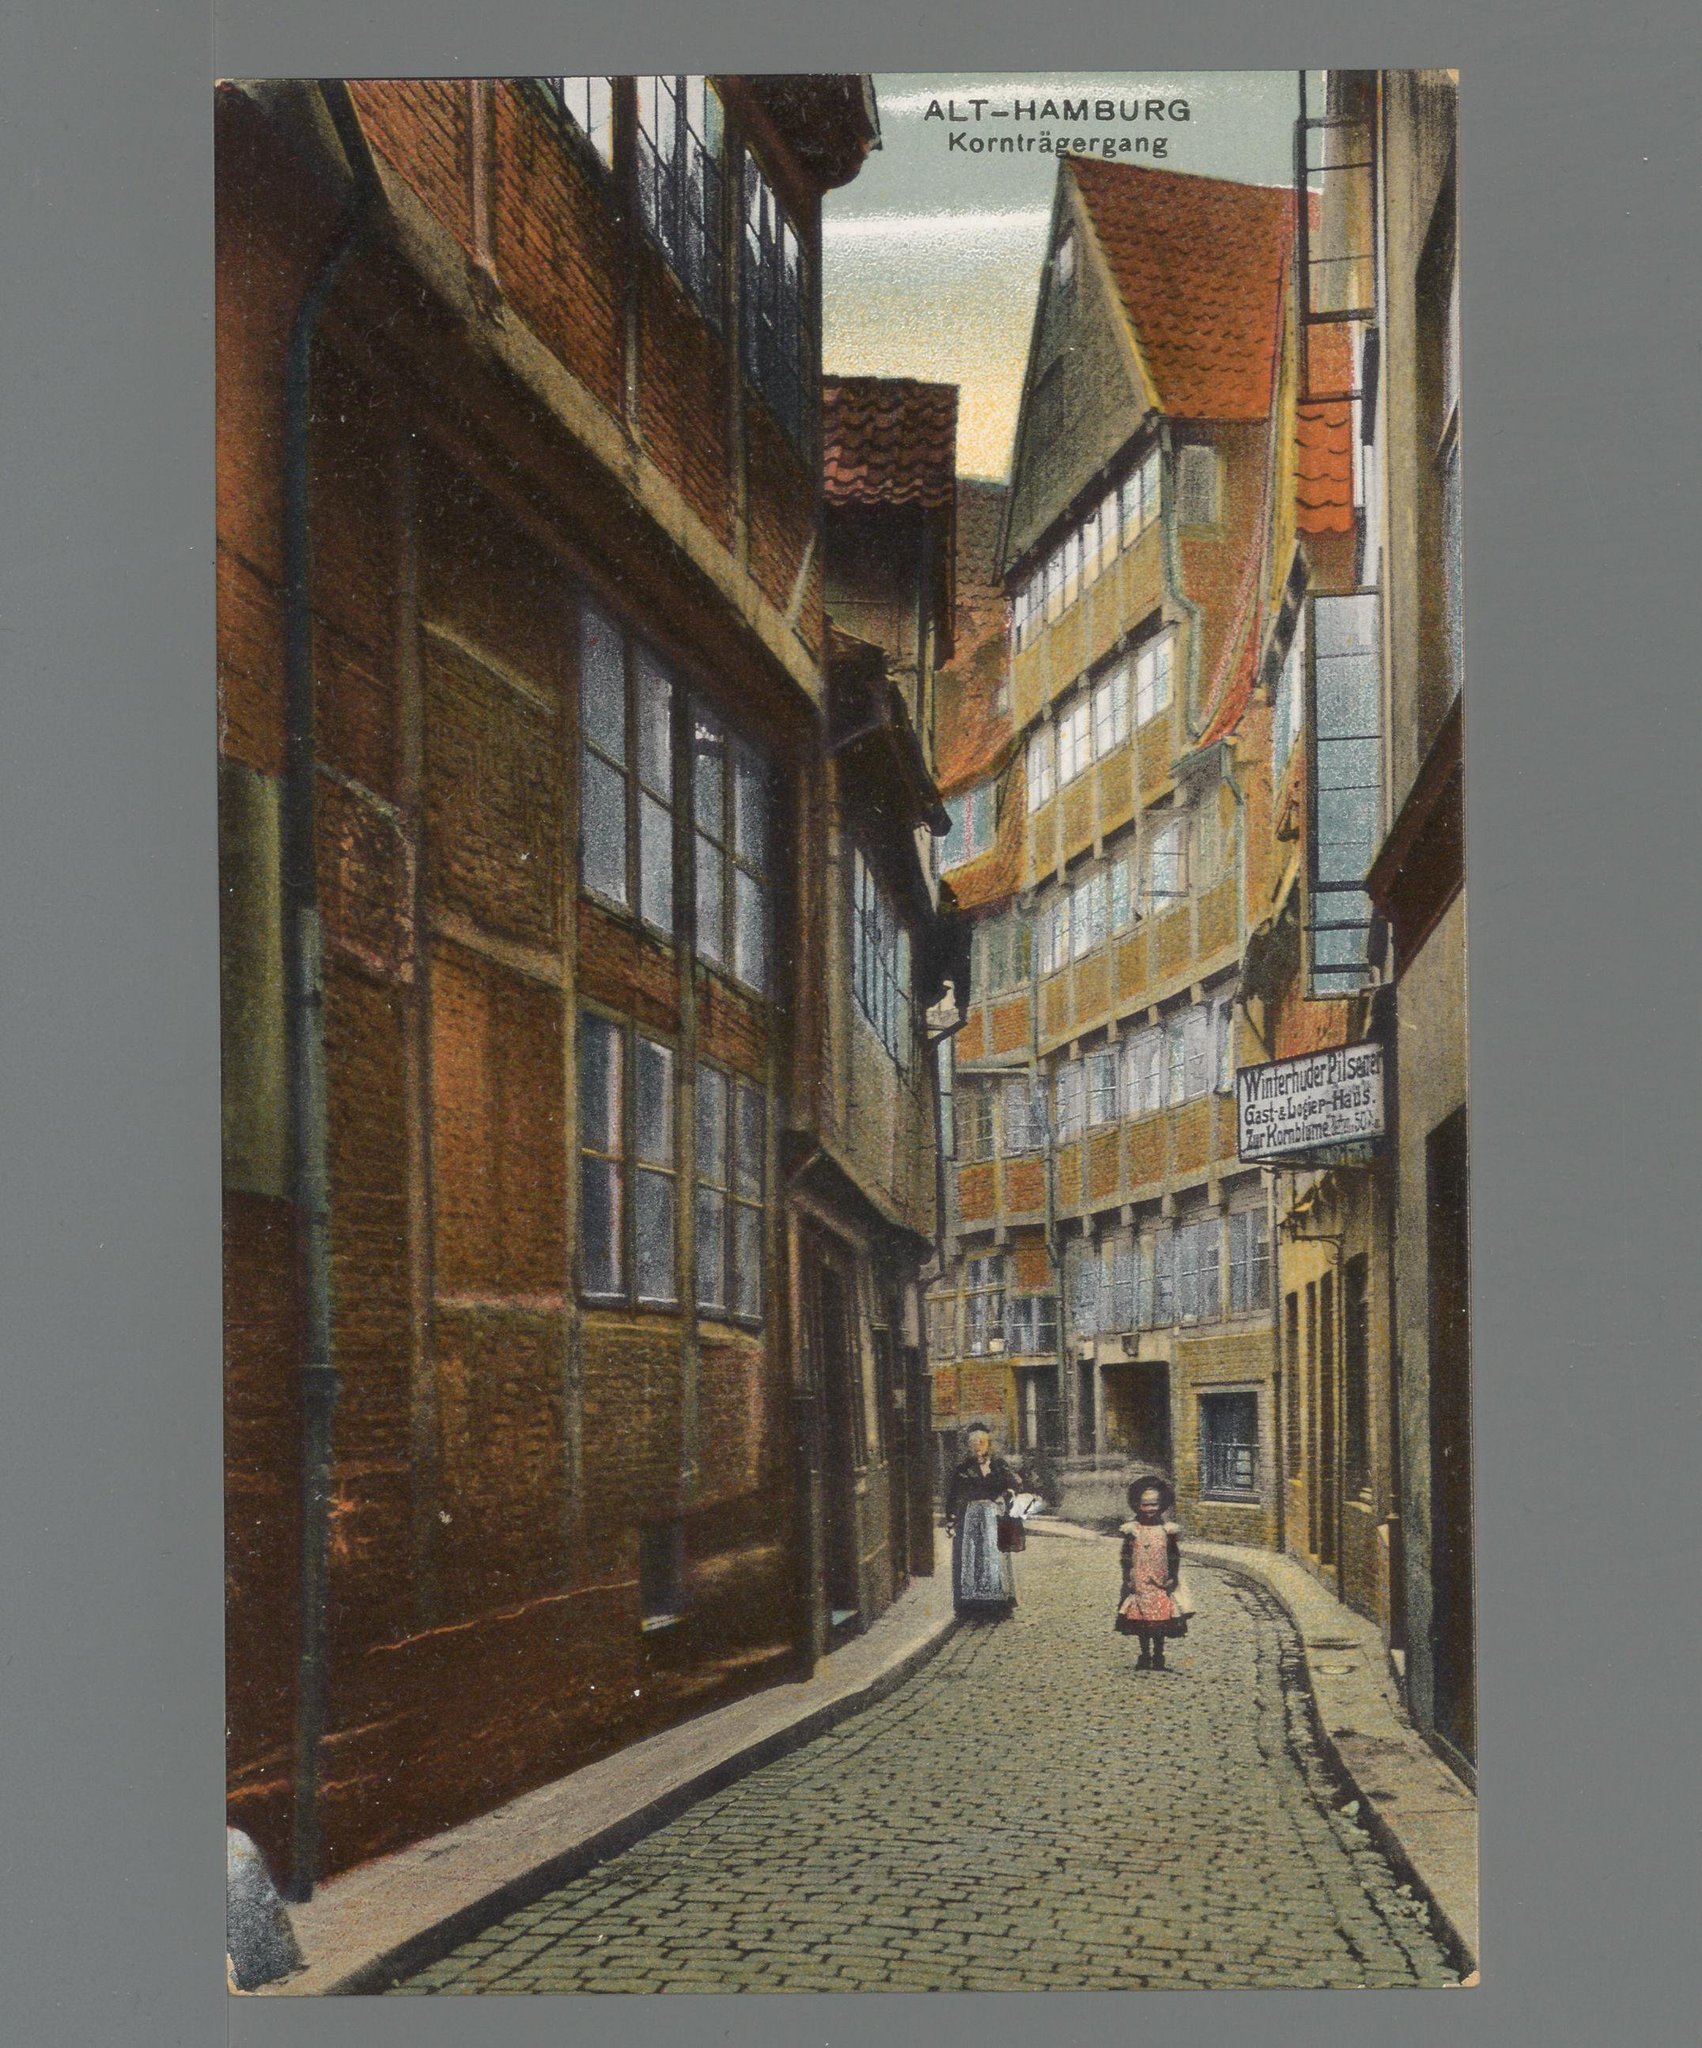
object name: photomechanical print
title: Alt-Hamburg. Kornträgergang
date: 1905-1930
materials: cardboard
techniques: photograph, lithograph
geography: hamburg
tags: street, hotel, hostelry, inn